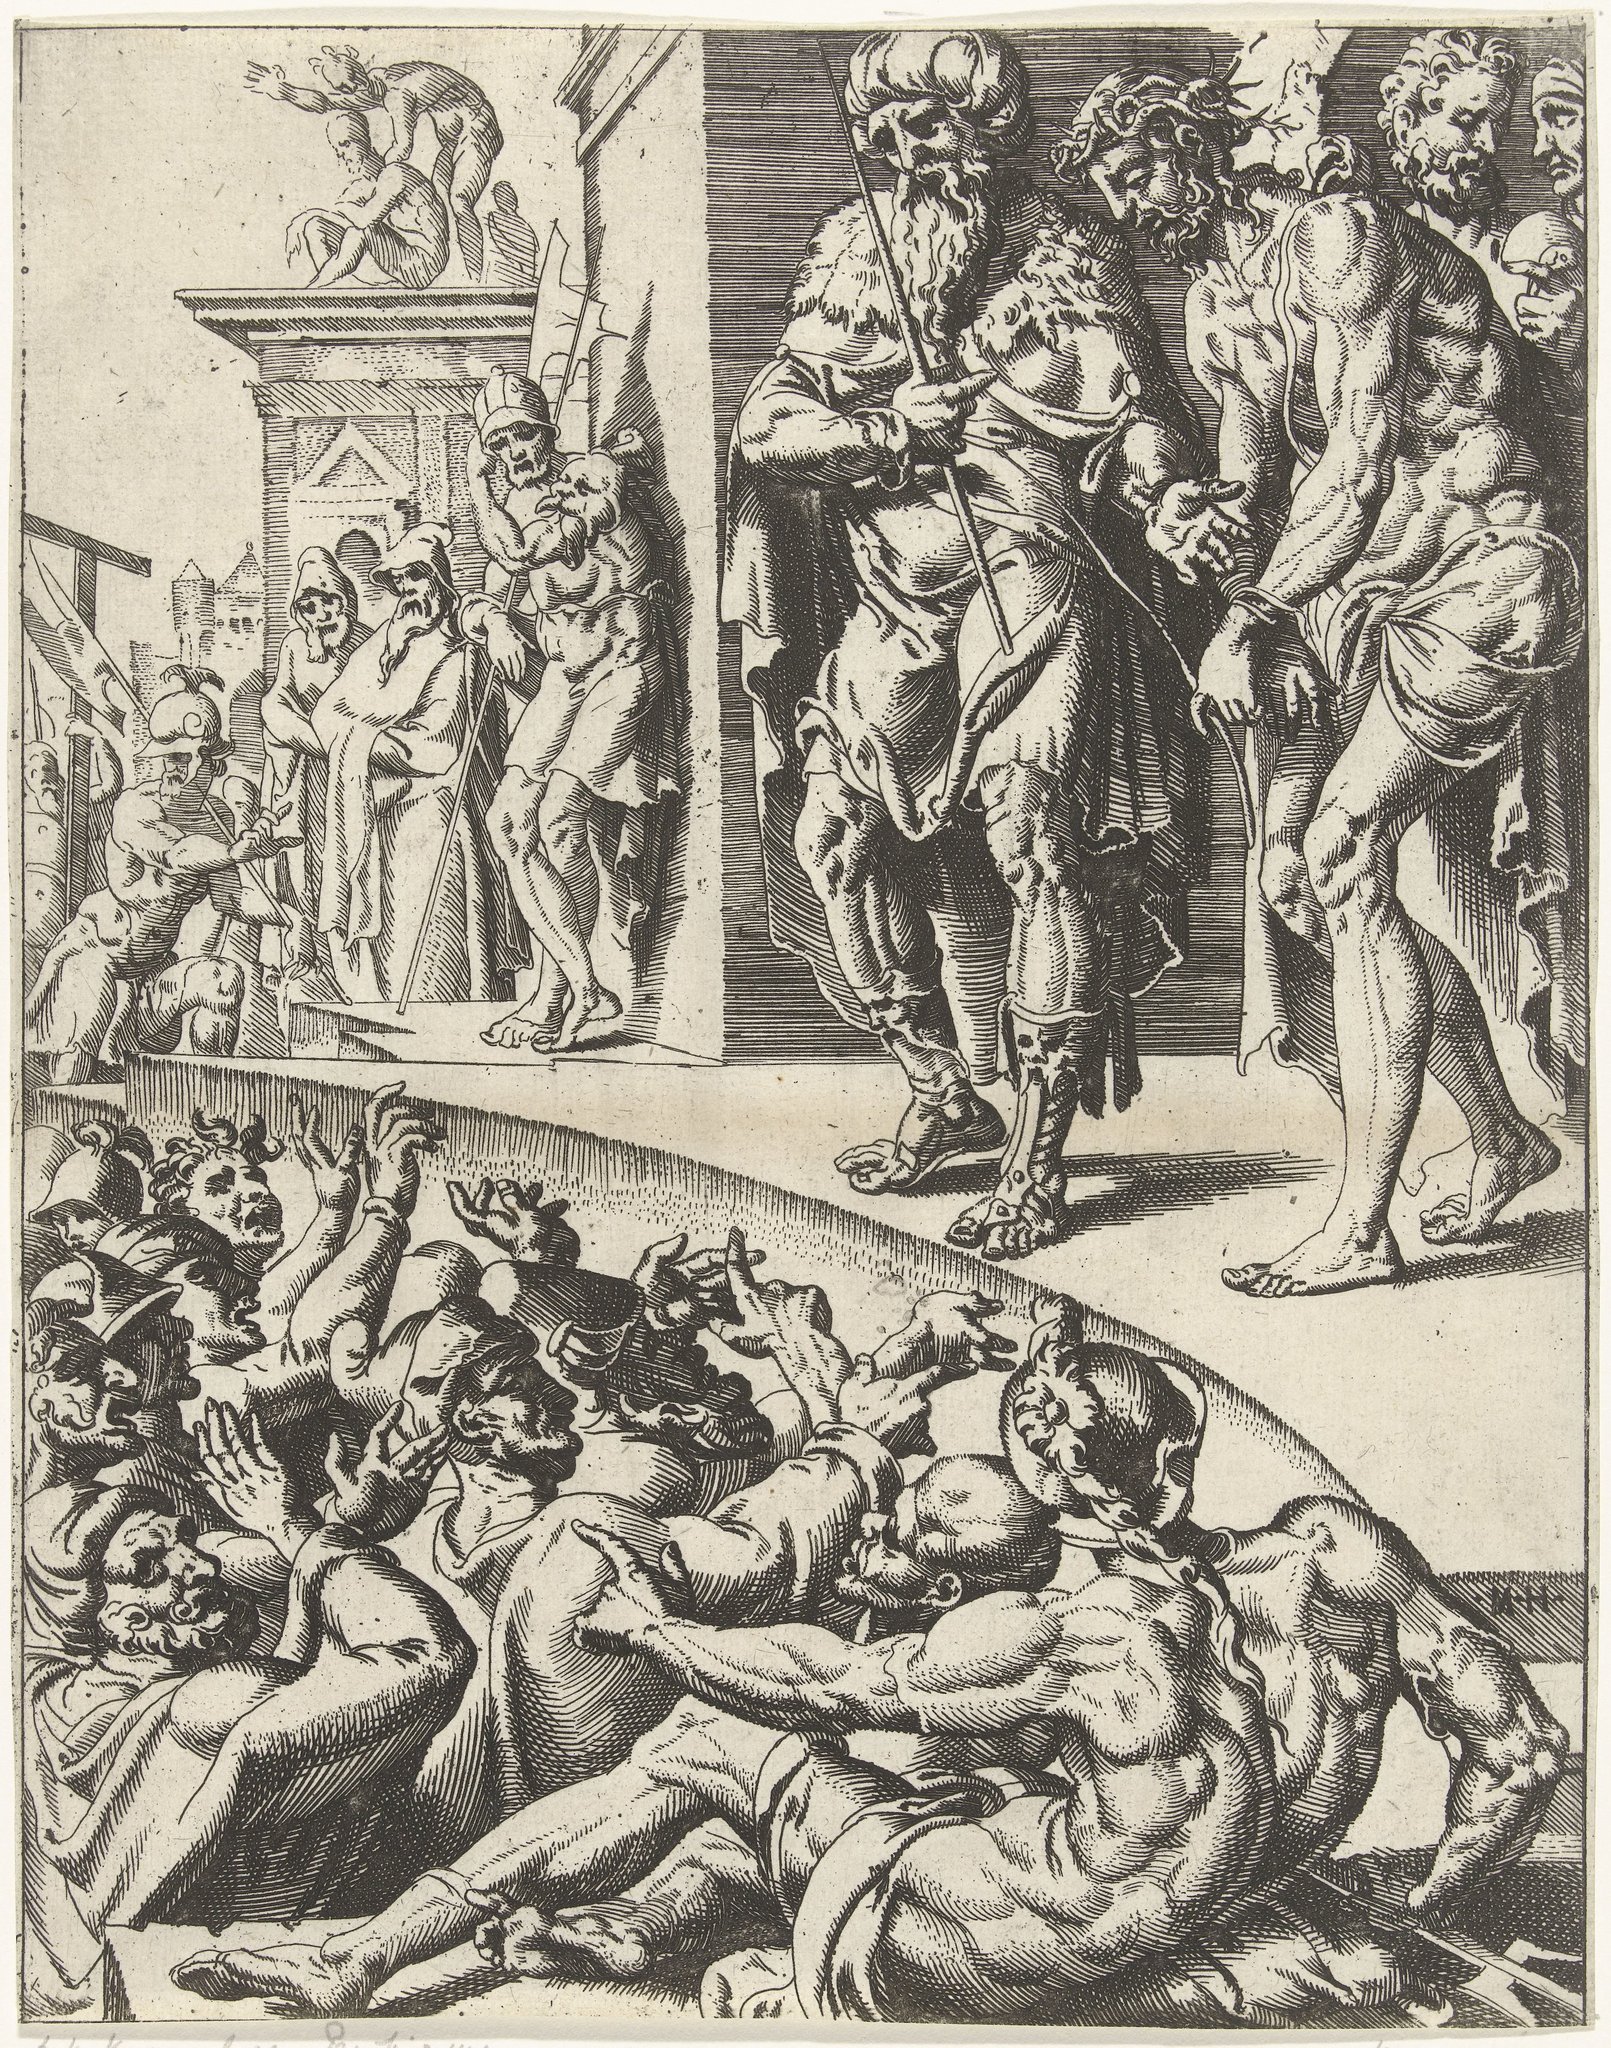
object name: print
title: Ecce Homo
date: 1548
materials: paper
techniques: etching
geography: haarlem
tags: pilate showing christ to the people, 'ostentatio christi', 'ecce homo' (john 19:4-6)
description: Pontius Pilatus toont de gegeselde Christus aan het Joodse volk. De prent is deel van een dertigdelige serie met prenten over de zondeval en Christus' passie.